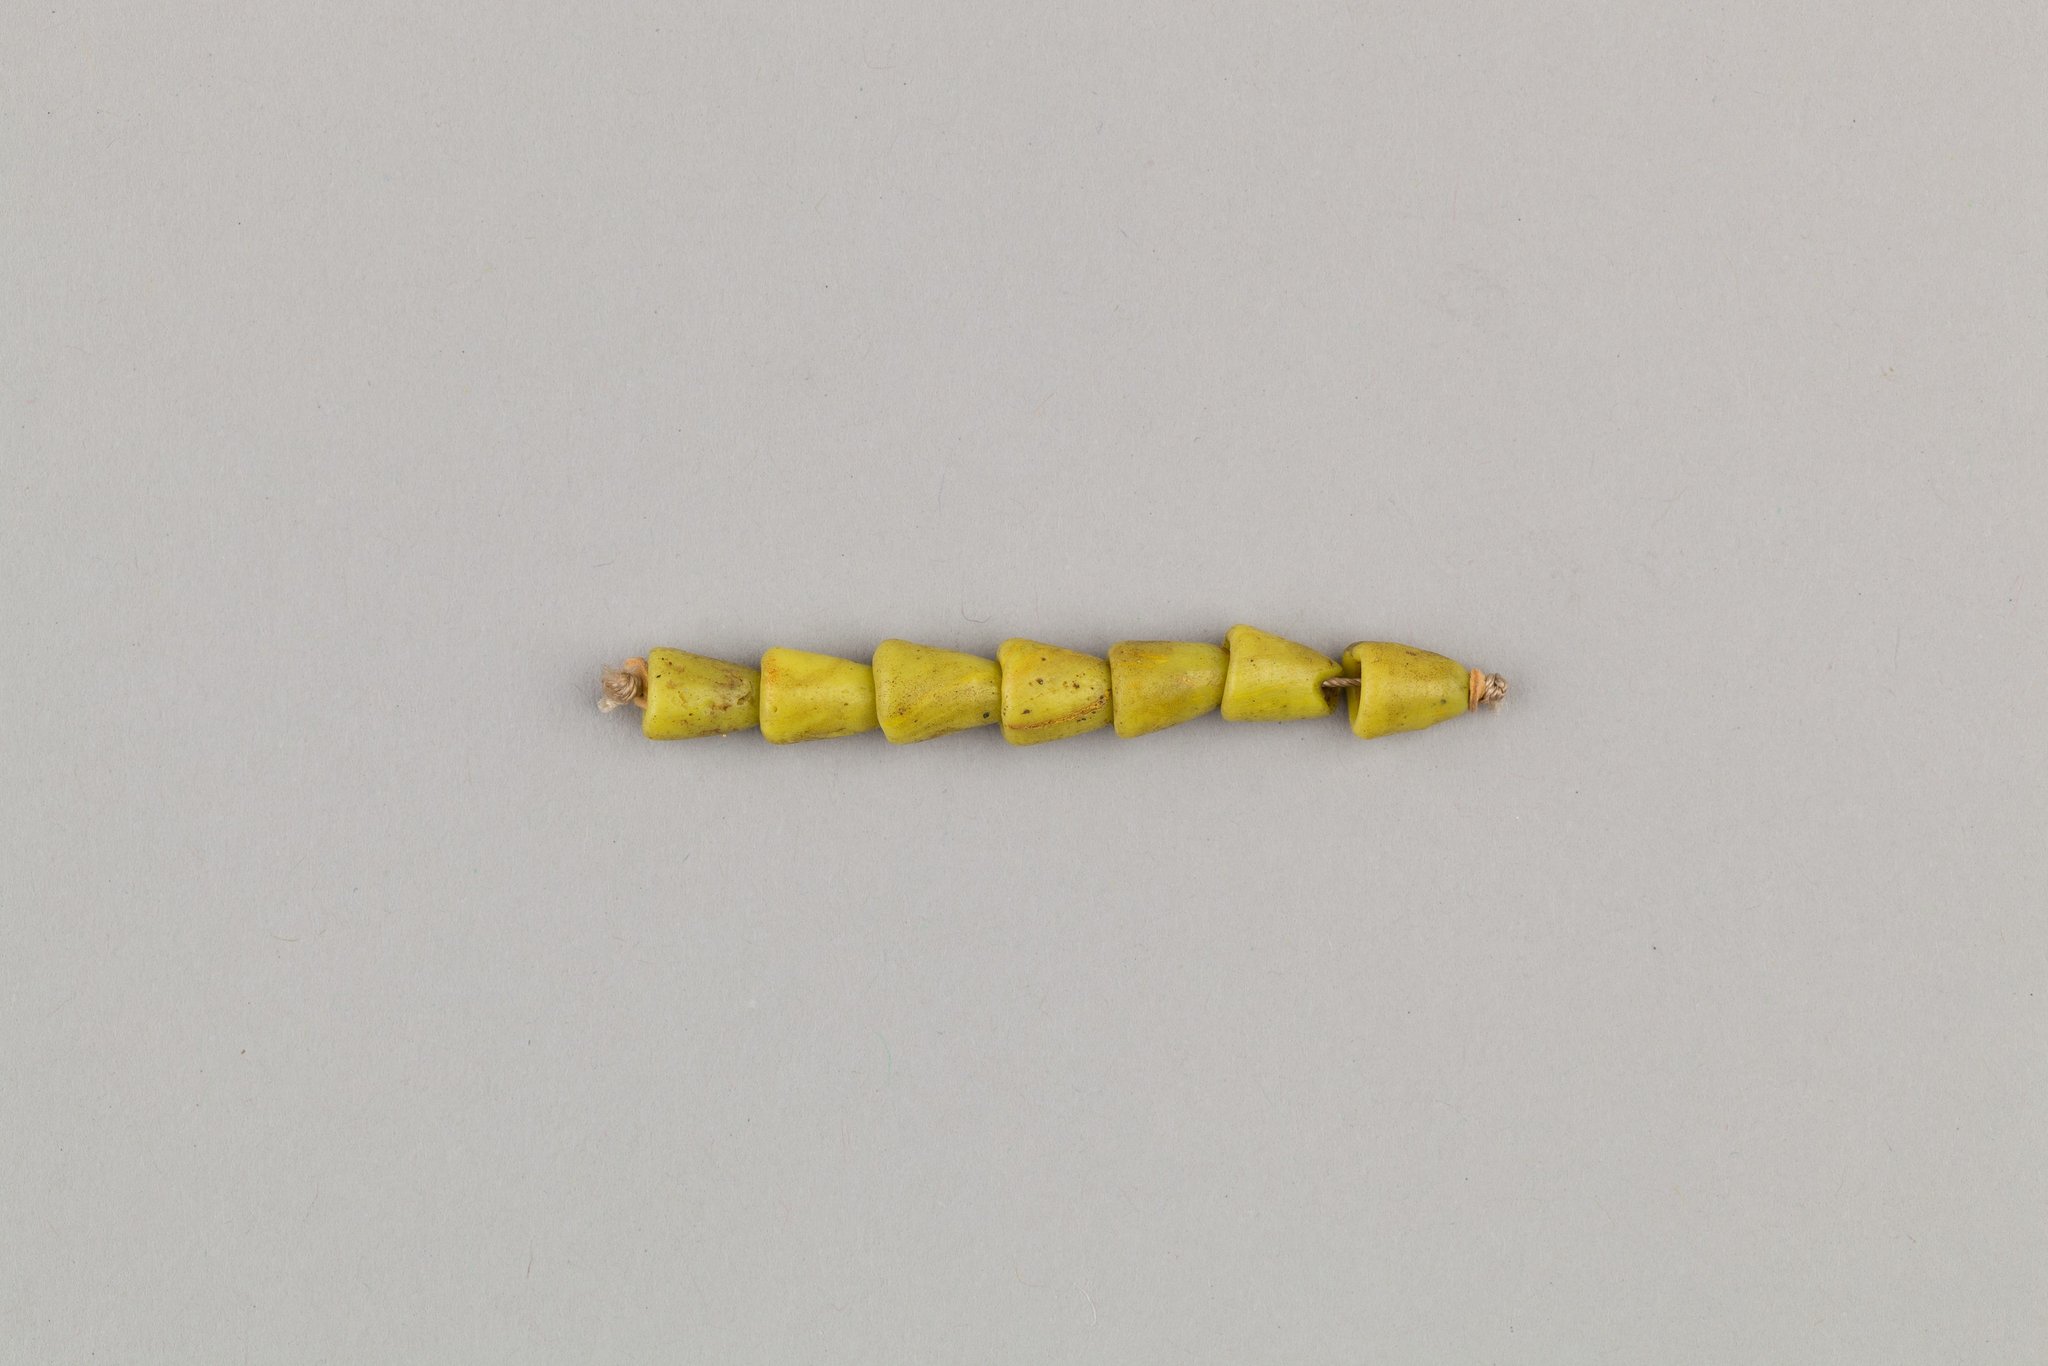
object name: bead, string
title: String of 7 beads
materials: glass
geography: egypt